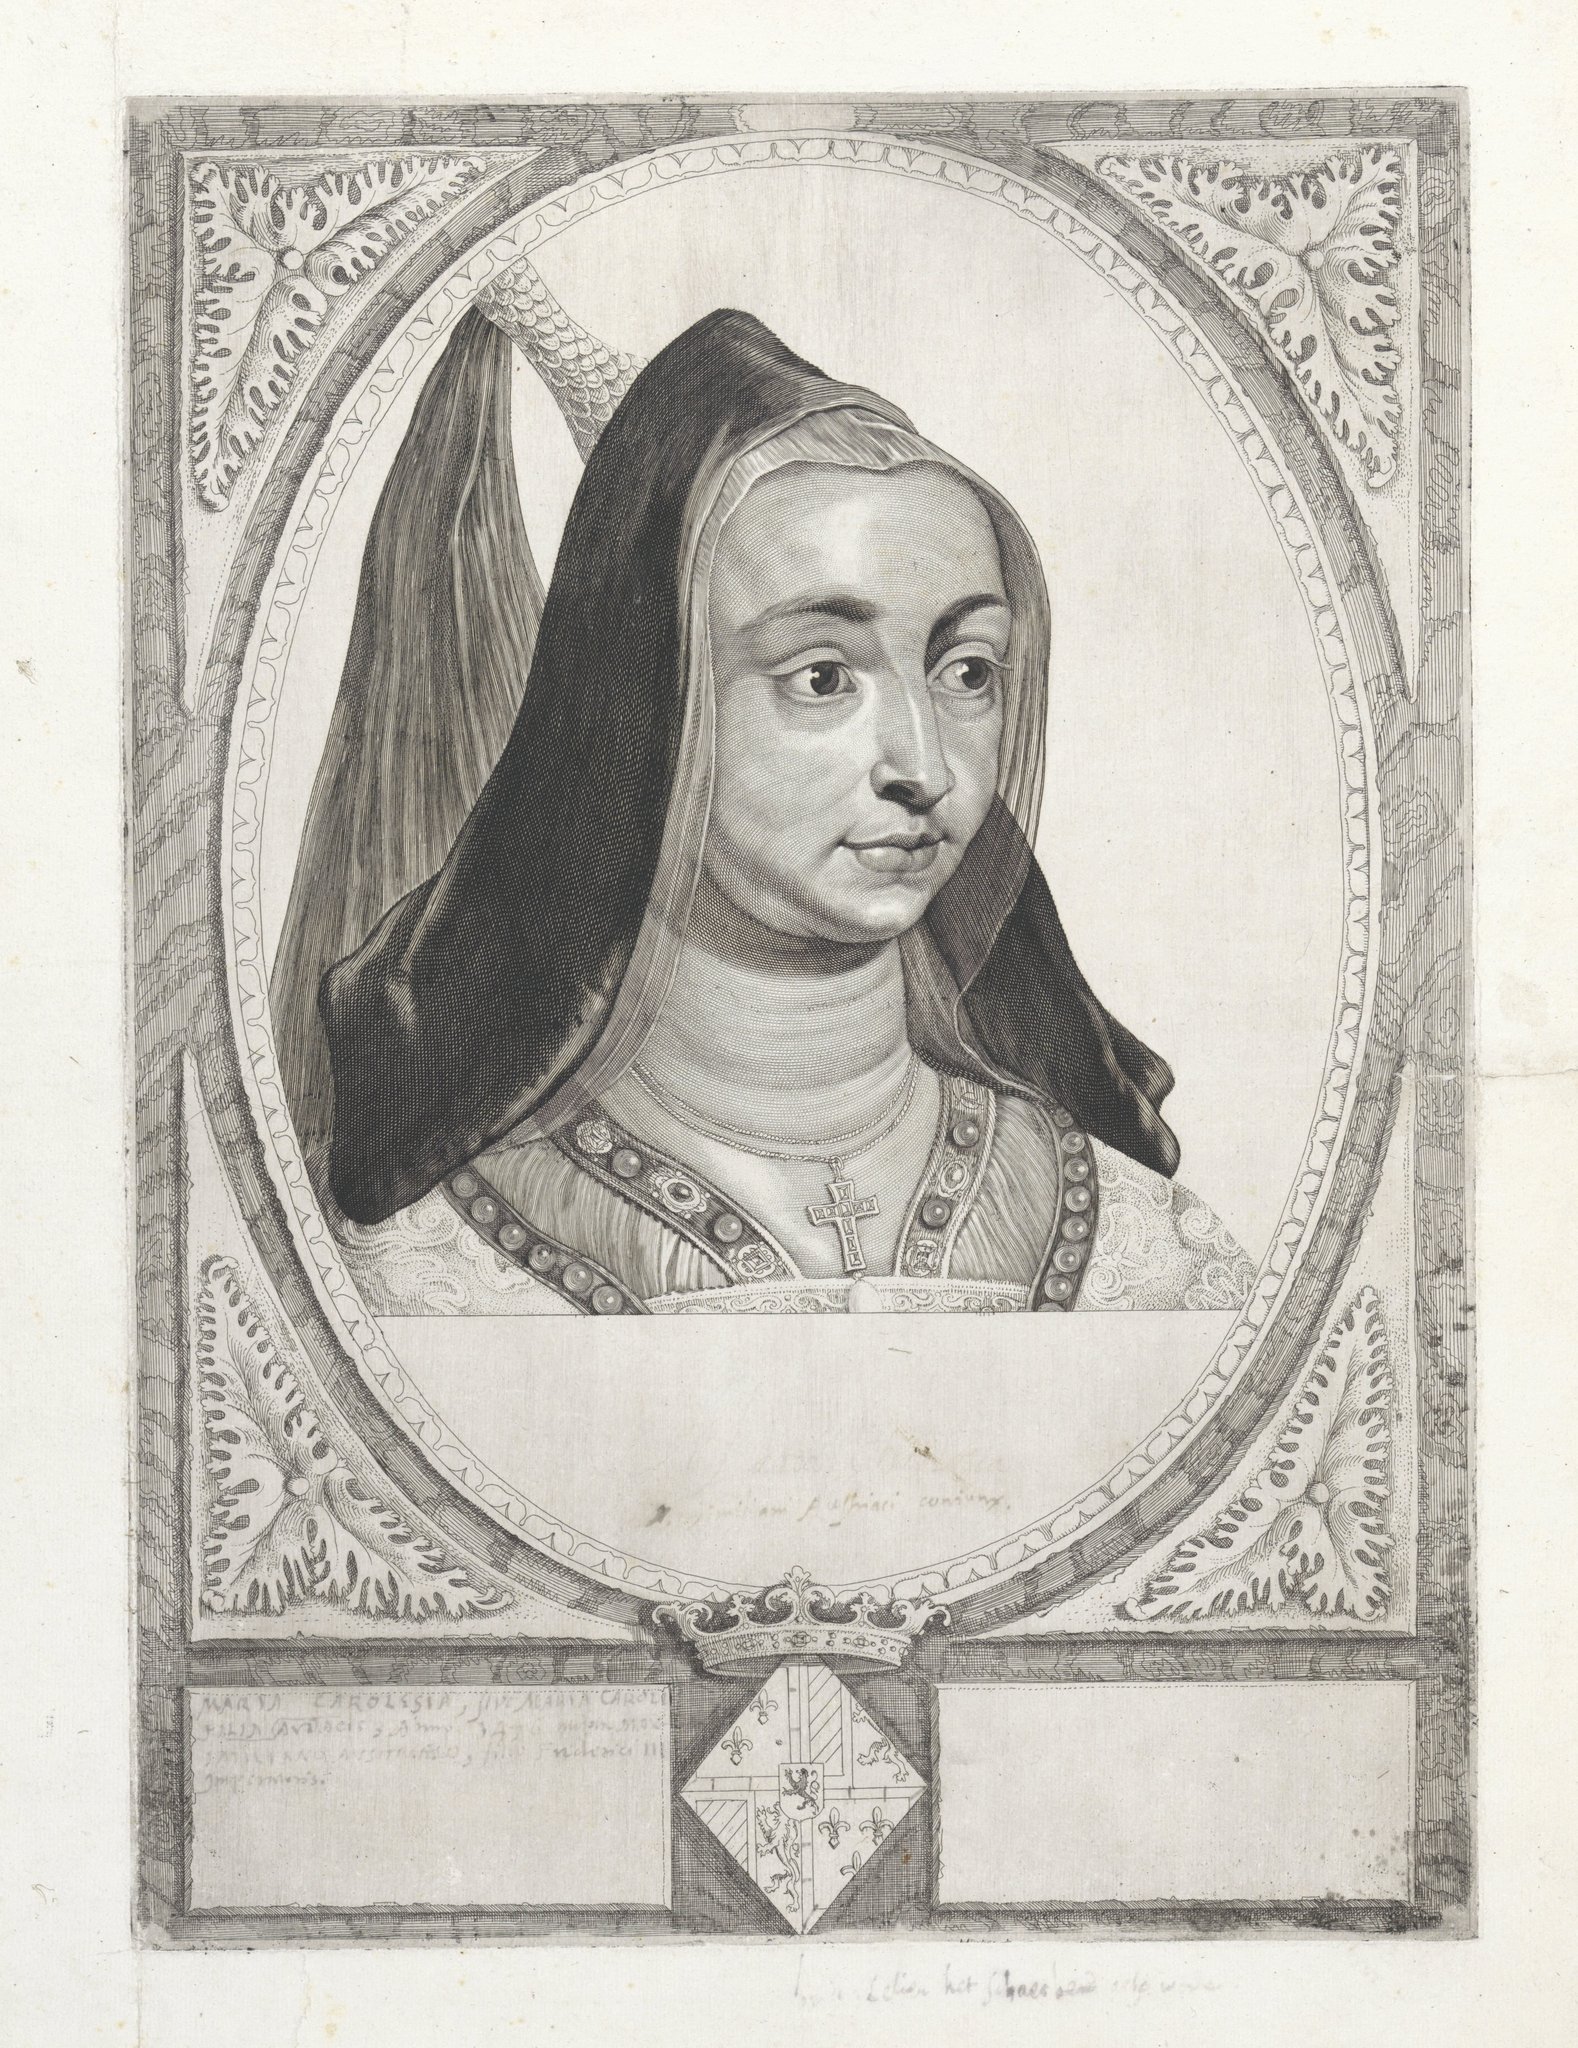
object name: print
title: Portret van Maria, hertogin van Bourgondië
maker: cornelis visscher (ii)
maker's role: draughtsman, painter, print maker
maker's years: 1628-1658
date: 1650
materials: paper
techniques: engraving, etching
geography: haarlem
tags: brussels, bruges, maria (hertogin van bourgondië), head-gear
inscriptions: inscription, collector's mark: Lugt 240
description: Proefdruk van de tweeendertigste prent uit de serie 'Graven en gravinnen van Holland, Zeeland en West-Friesland', bestaande uit 38 prenten.